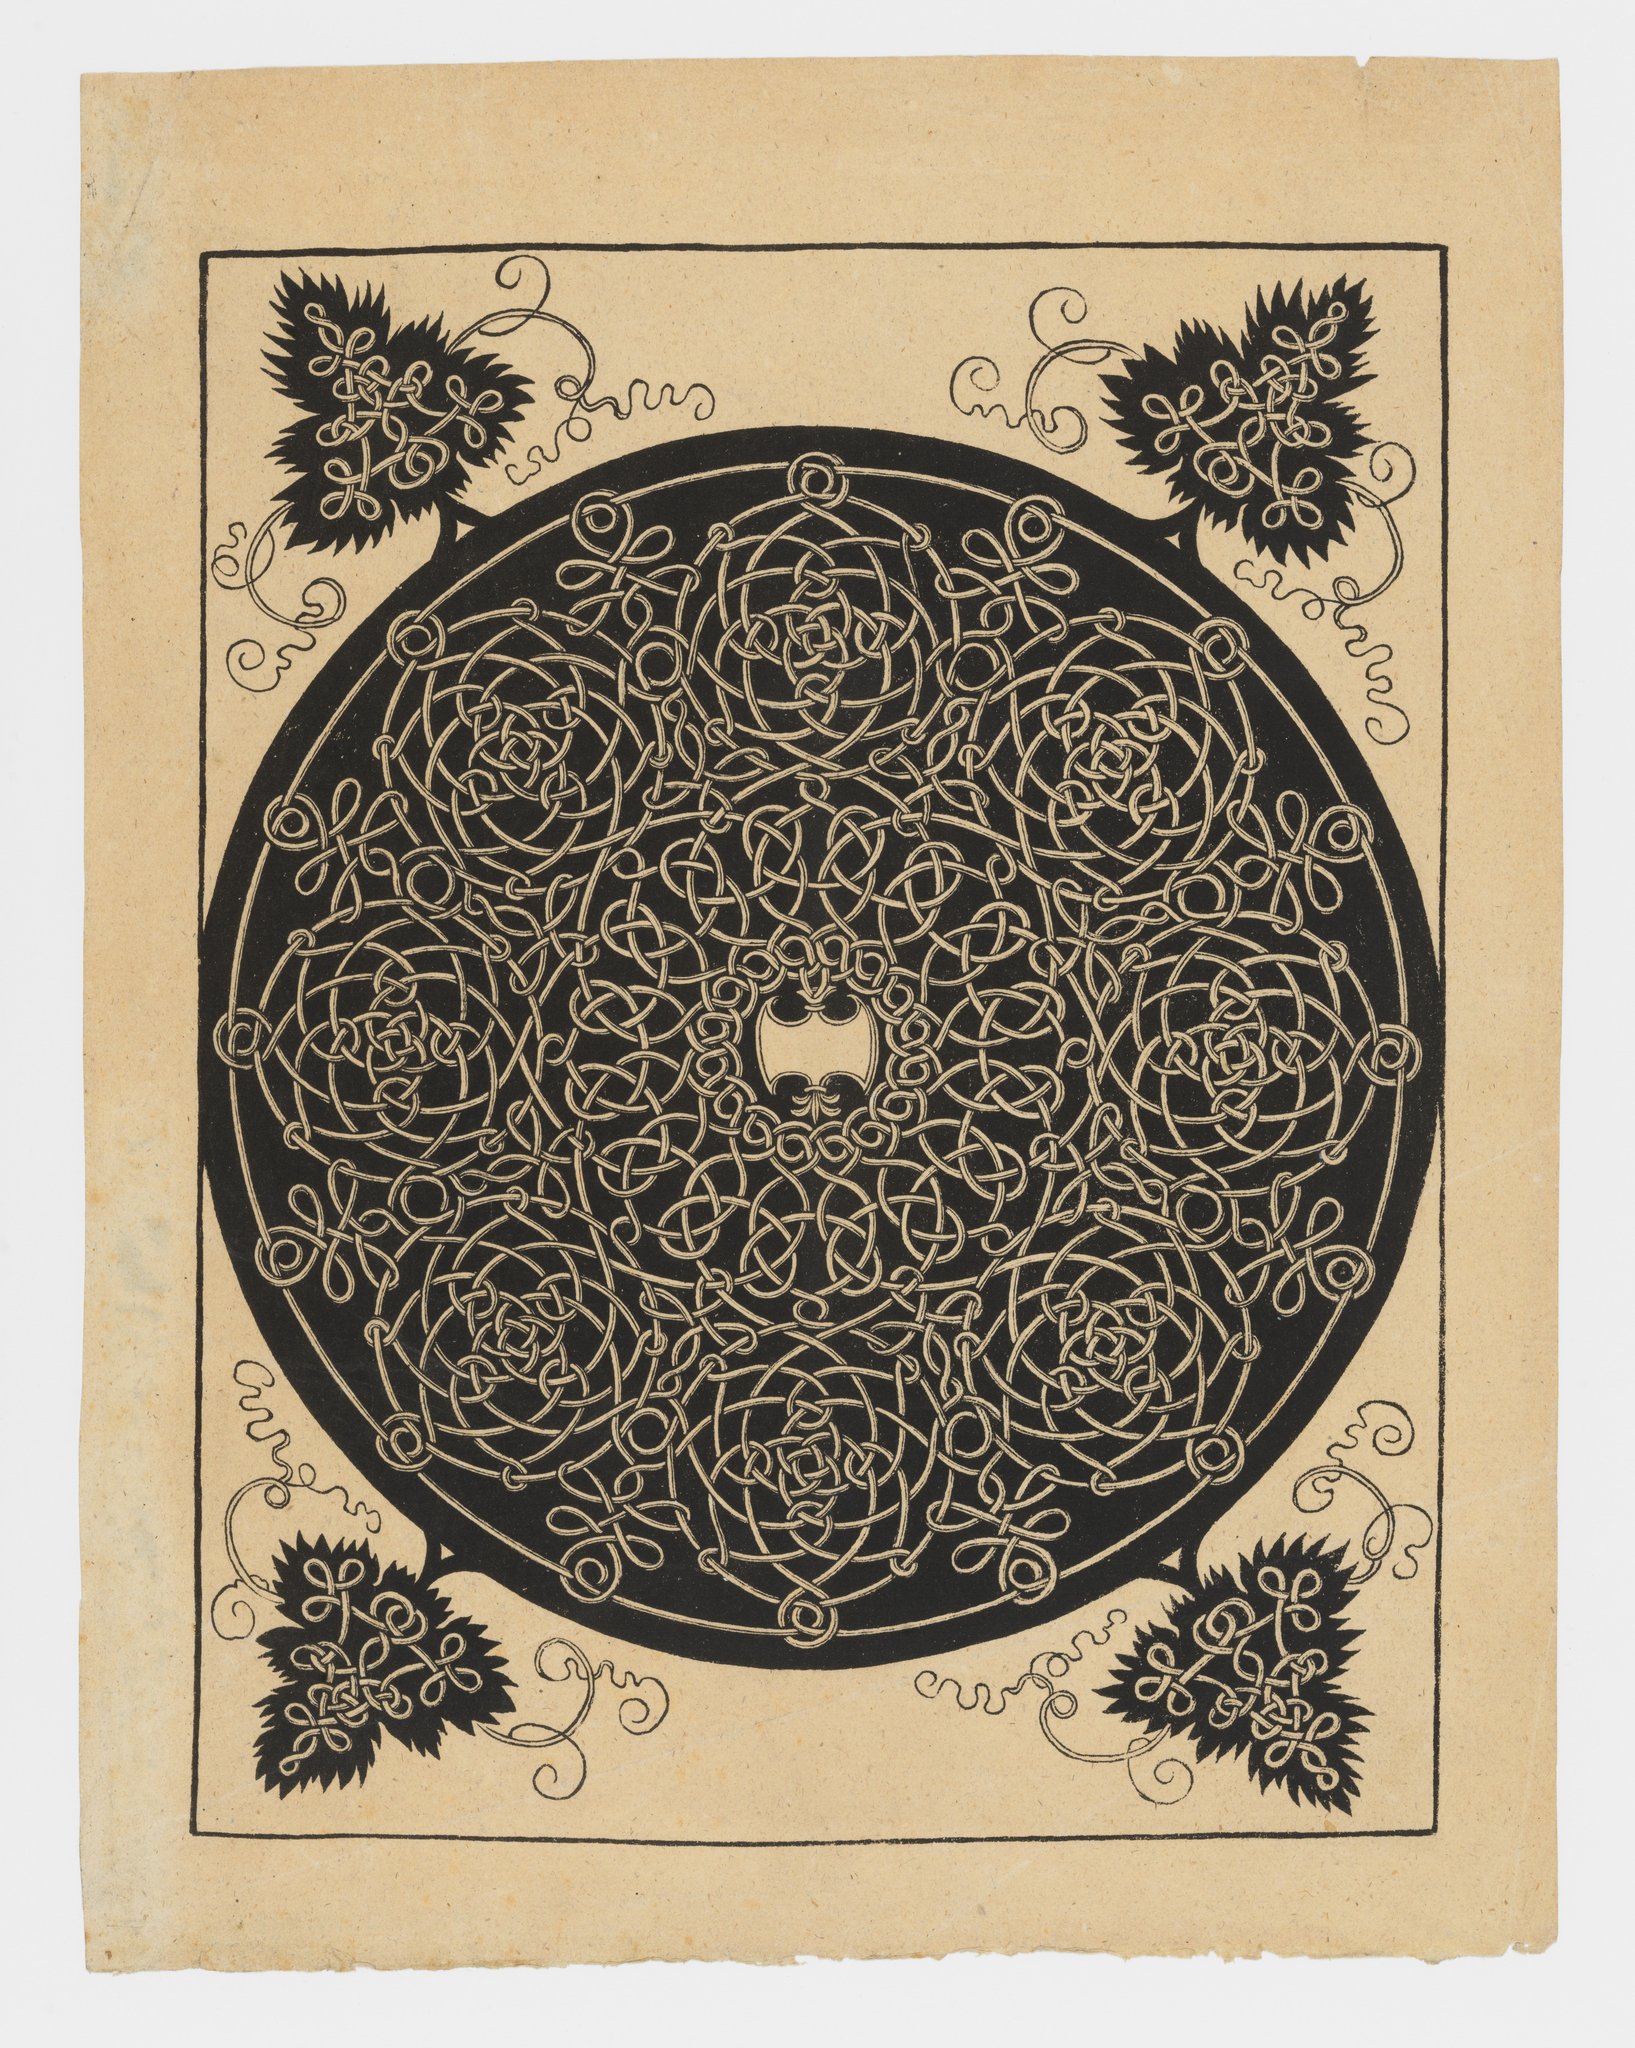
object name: print ornament architecture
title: Facsimile of Albrecht Dürer’s Third Knot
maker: ralf leopold von retberg-wettbergen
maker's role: artist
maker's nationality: german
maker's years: 1812-1885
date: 1865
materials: paper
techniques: lithograph